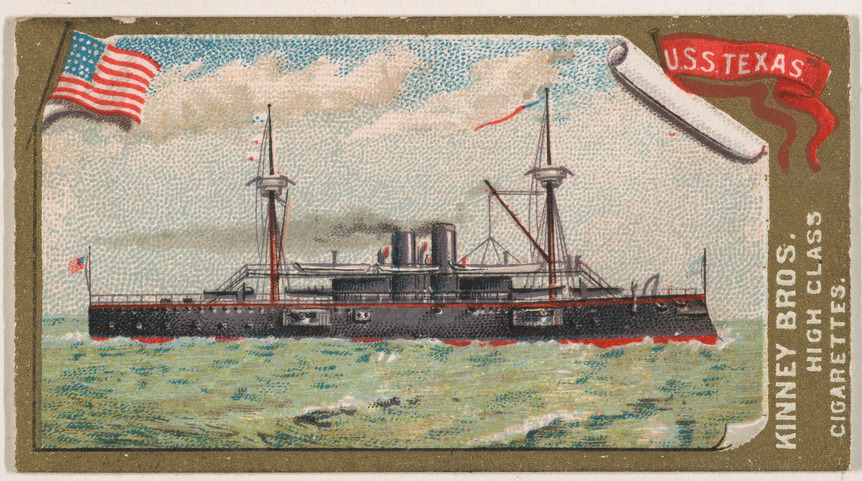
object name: print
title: U.S.S. Texas, from the Naval Vessels of the World series (N226) issued by Kinney Bros.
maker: kinney brothers tobacco company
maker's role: publisher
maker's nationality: american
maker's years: 1869-2011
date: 1889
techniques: color lithograph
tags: navy,flags,ships